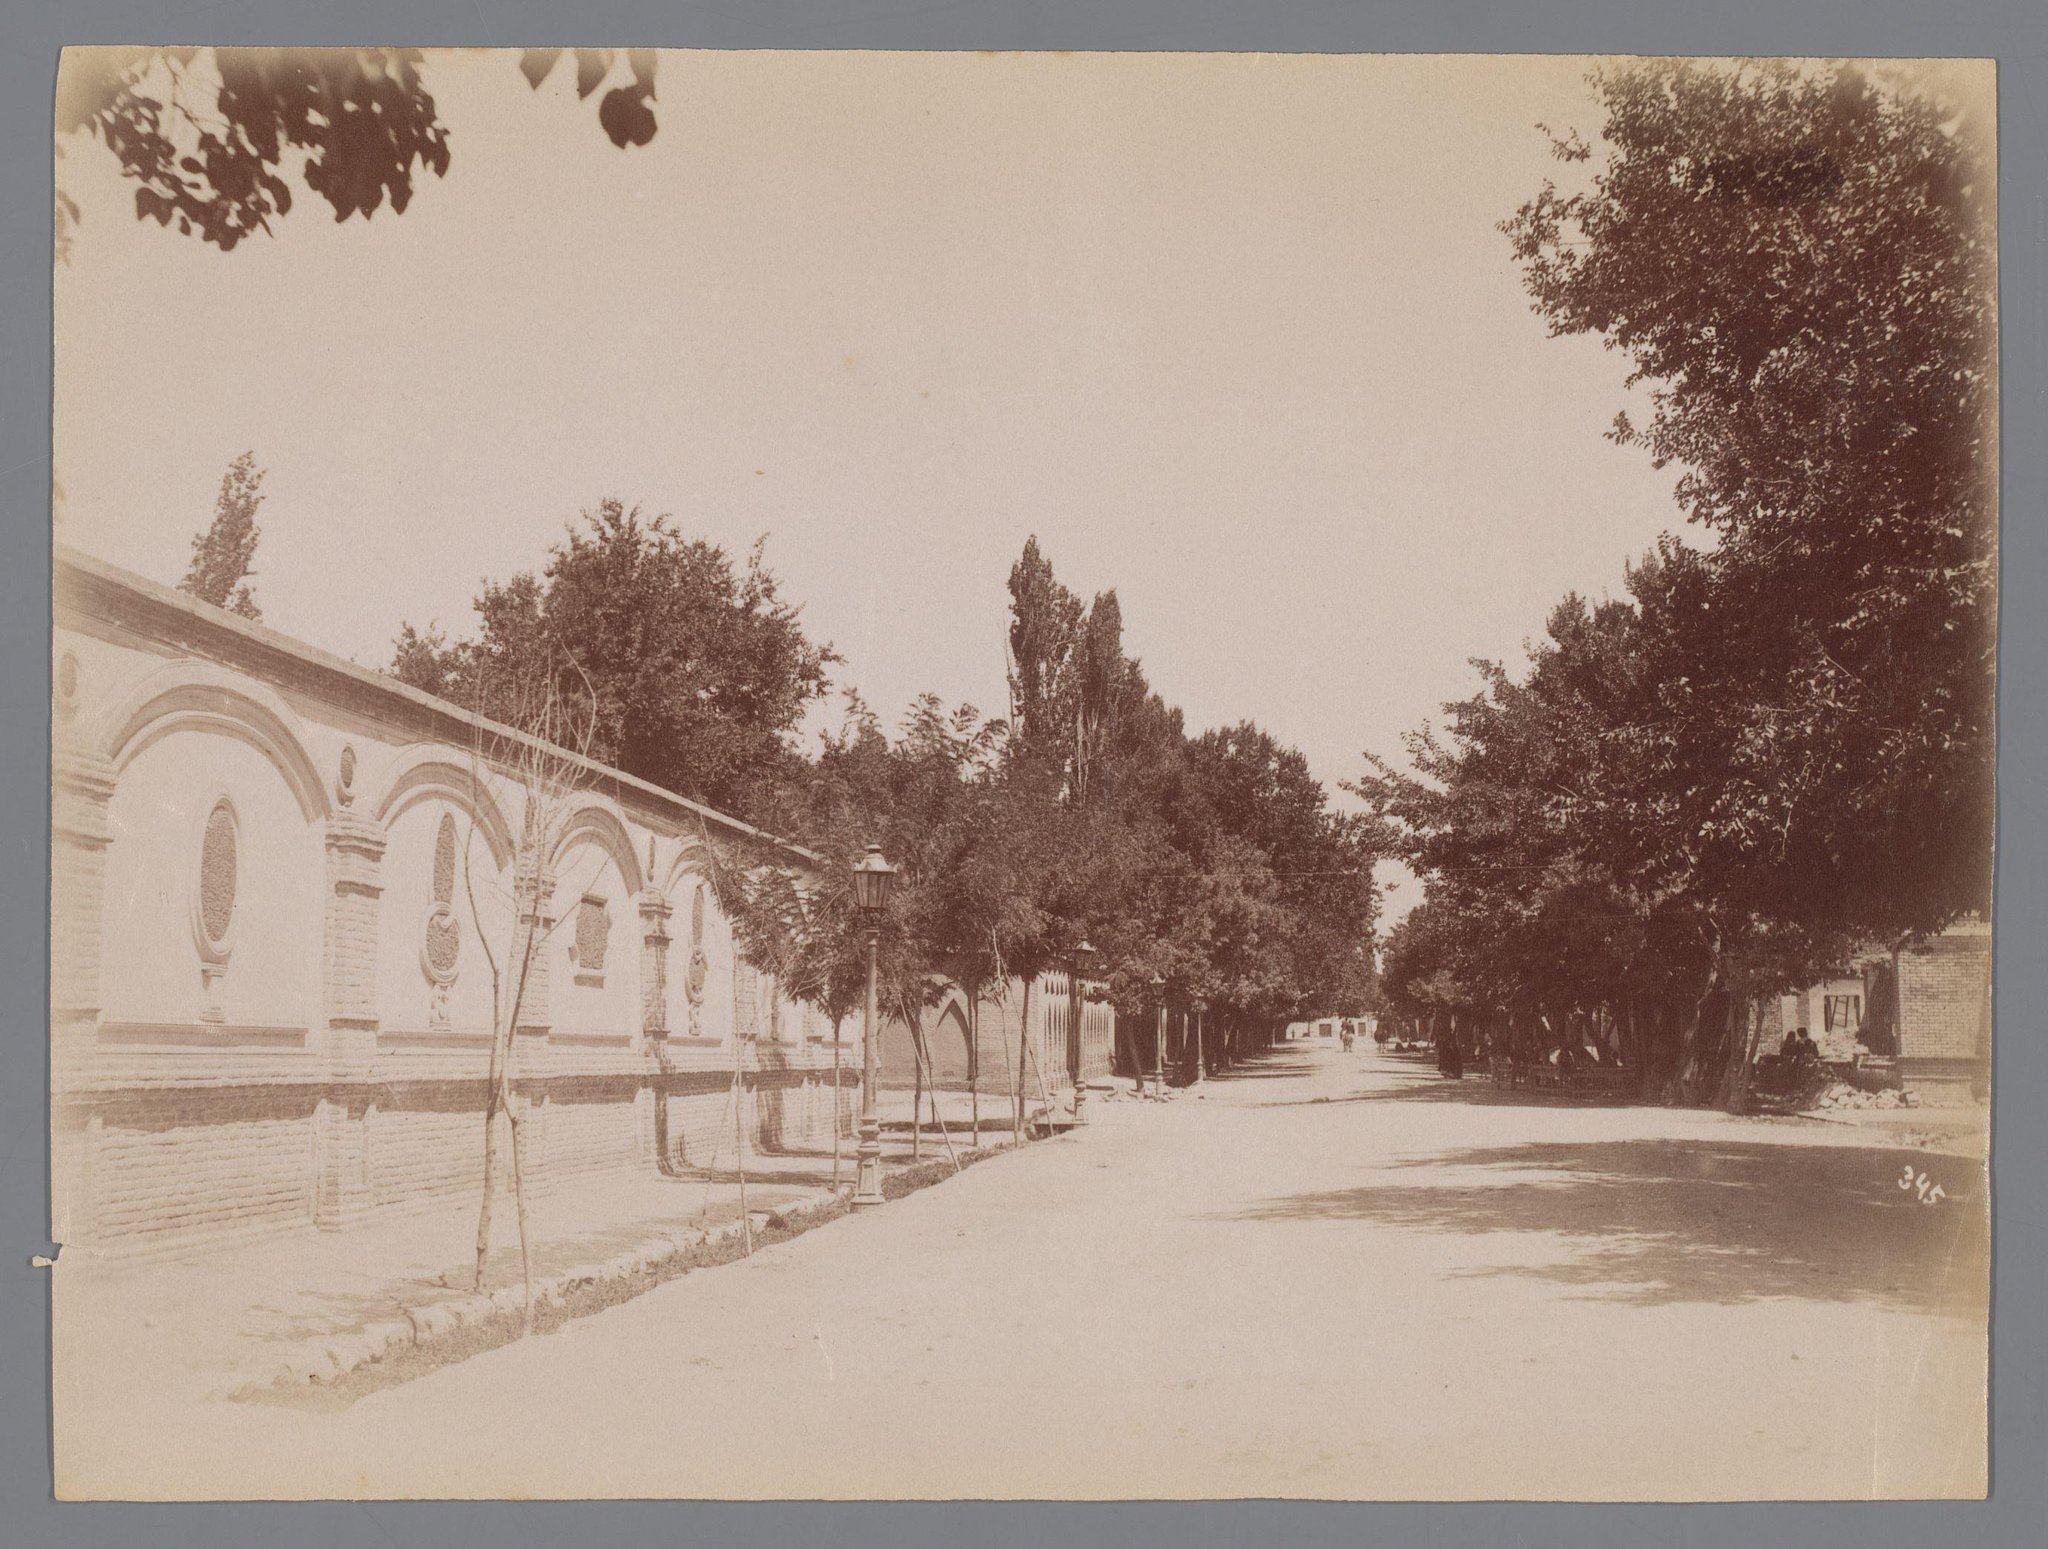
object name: photograph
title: Teheran, Avenue Alarbouleh [?], Iran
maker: antoine sevruguin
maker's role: fotograaf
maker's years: 1840-1933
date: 1880-1910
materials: paper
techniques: albumen print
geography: iran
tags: teheran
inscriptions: inscription: ‘Teheran, Topkaneh’, number: ‘14.’, number: ‘345’